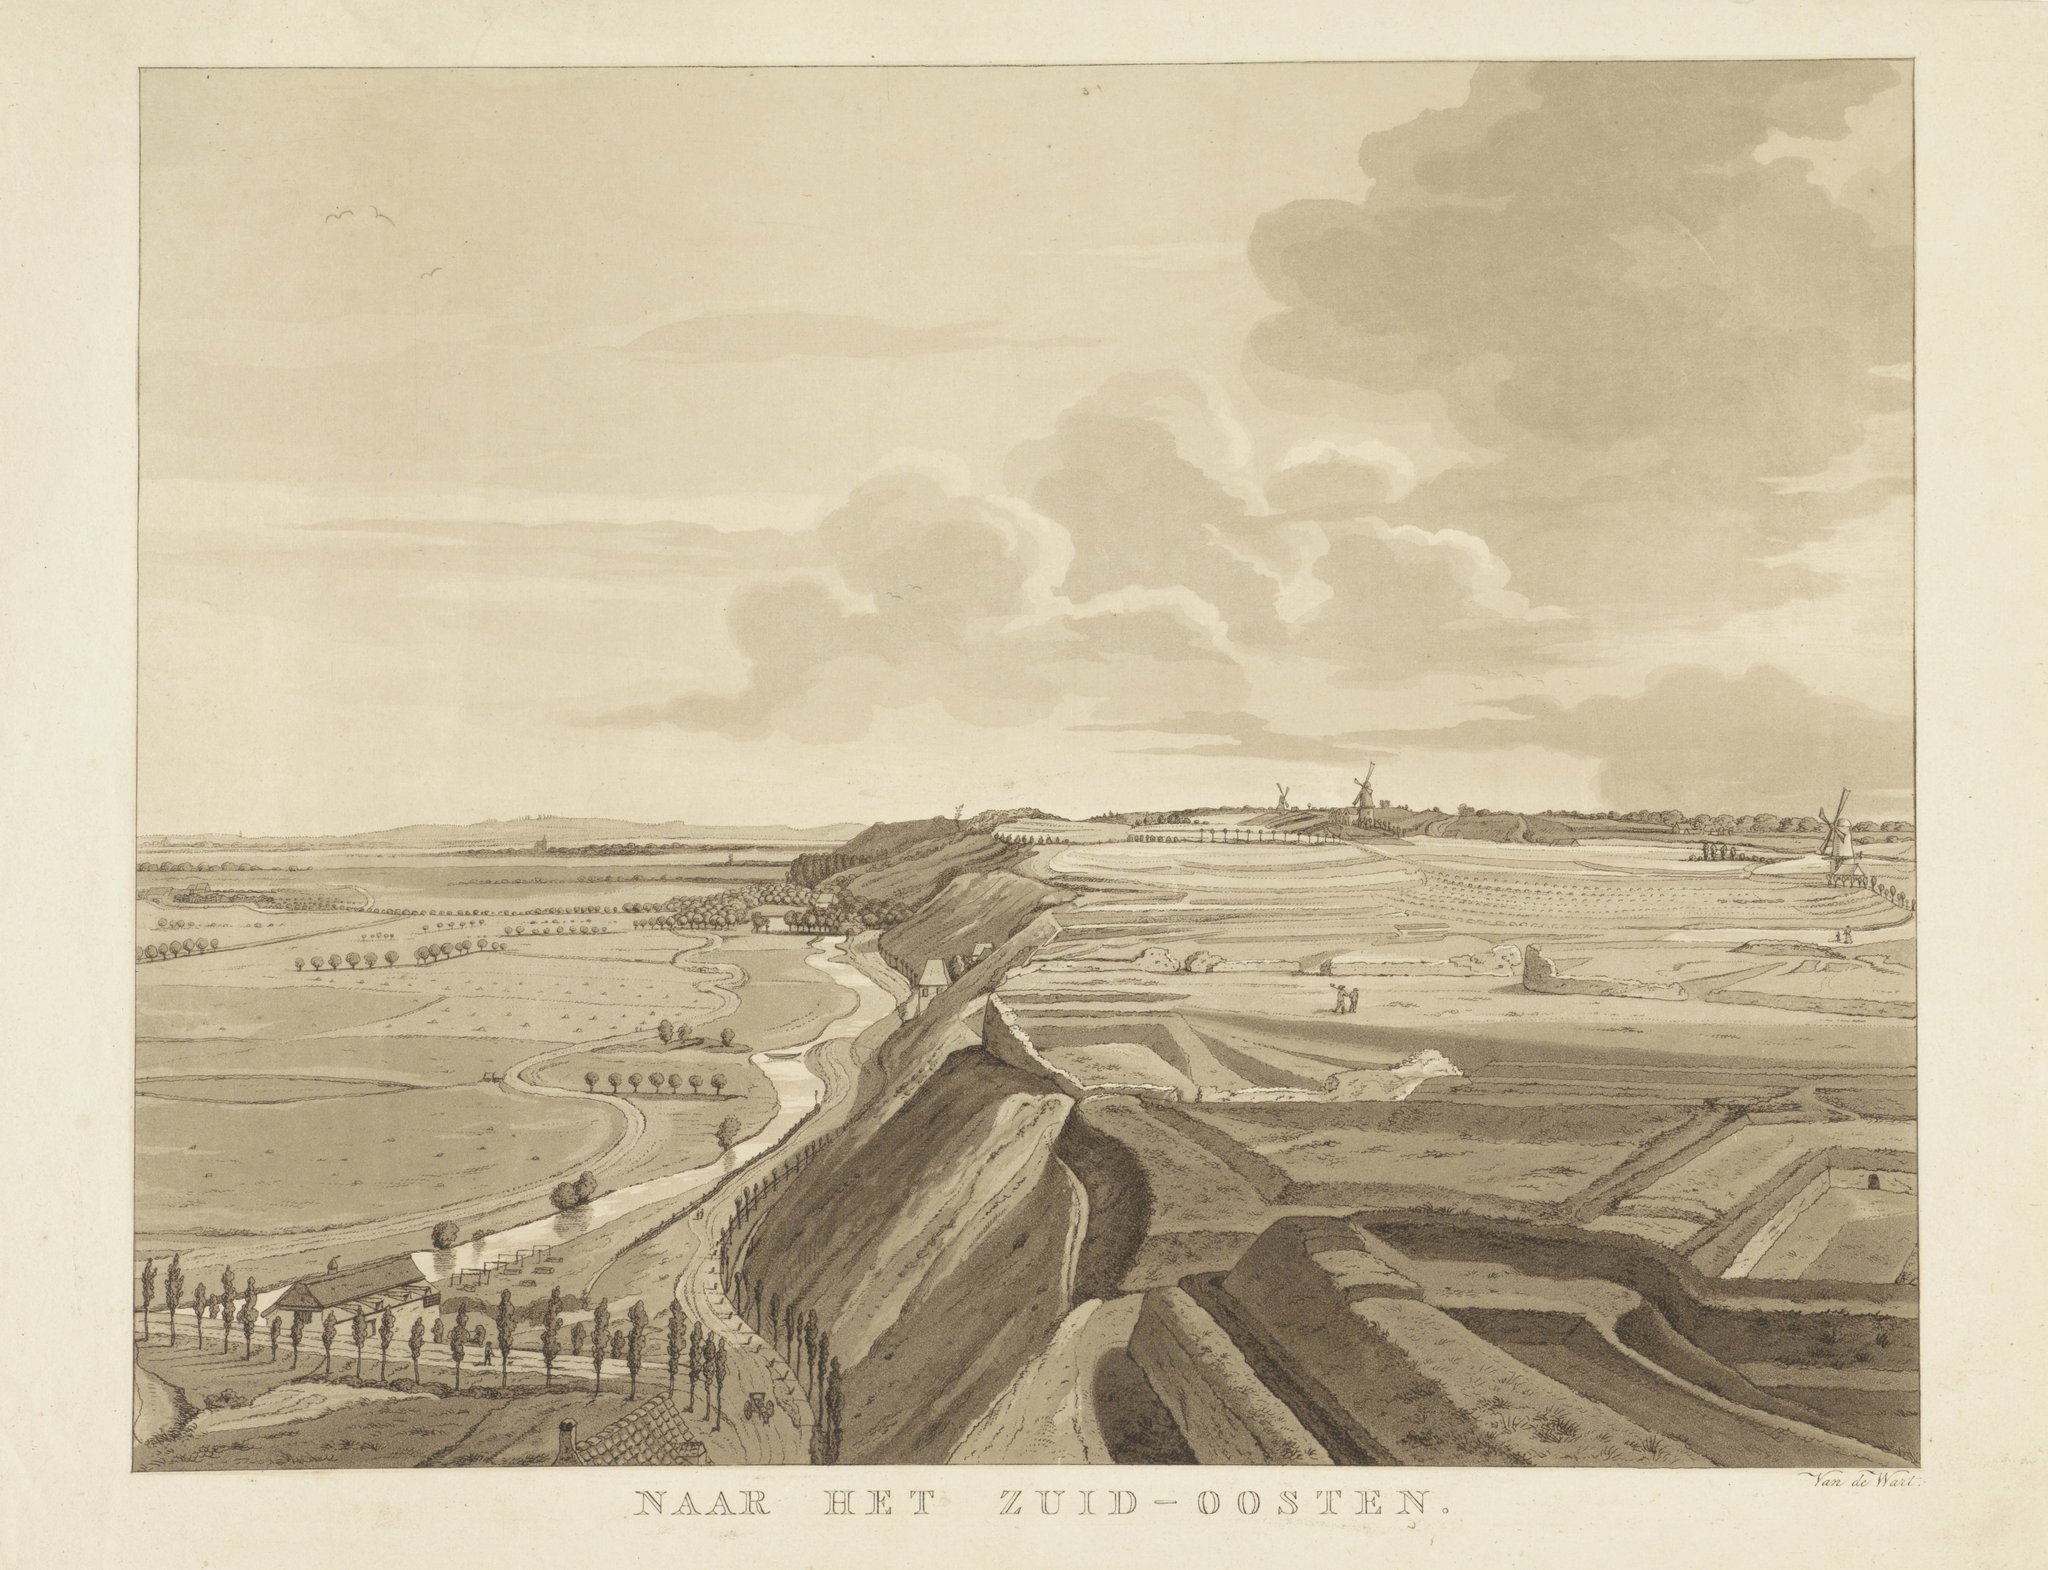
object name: print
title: Gezicht op het landschap ten zuidoosten van Nijmegen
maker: derk anthony van de wart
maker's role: draughtsman, painter, print maker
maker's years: 1767-1824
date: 1815-1824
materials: paper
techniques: aquatint, etching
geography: nijmegen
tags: windmill in landscape, nijmegen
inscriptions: collector's mark: Lugt 2228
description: Landschap ten zuidoosten van Nijmegen met enkele molens en een stuwwal. De prent is een onderdeel van een suite van negen prenten, inclusief de titelprent.